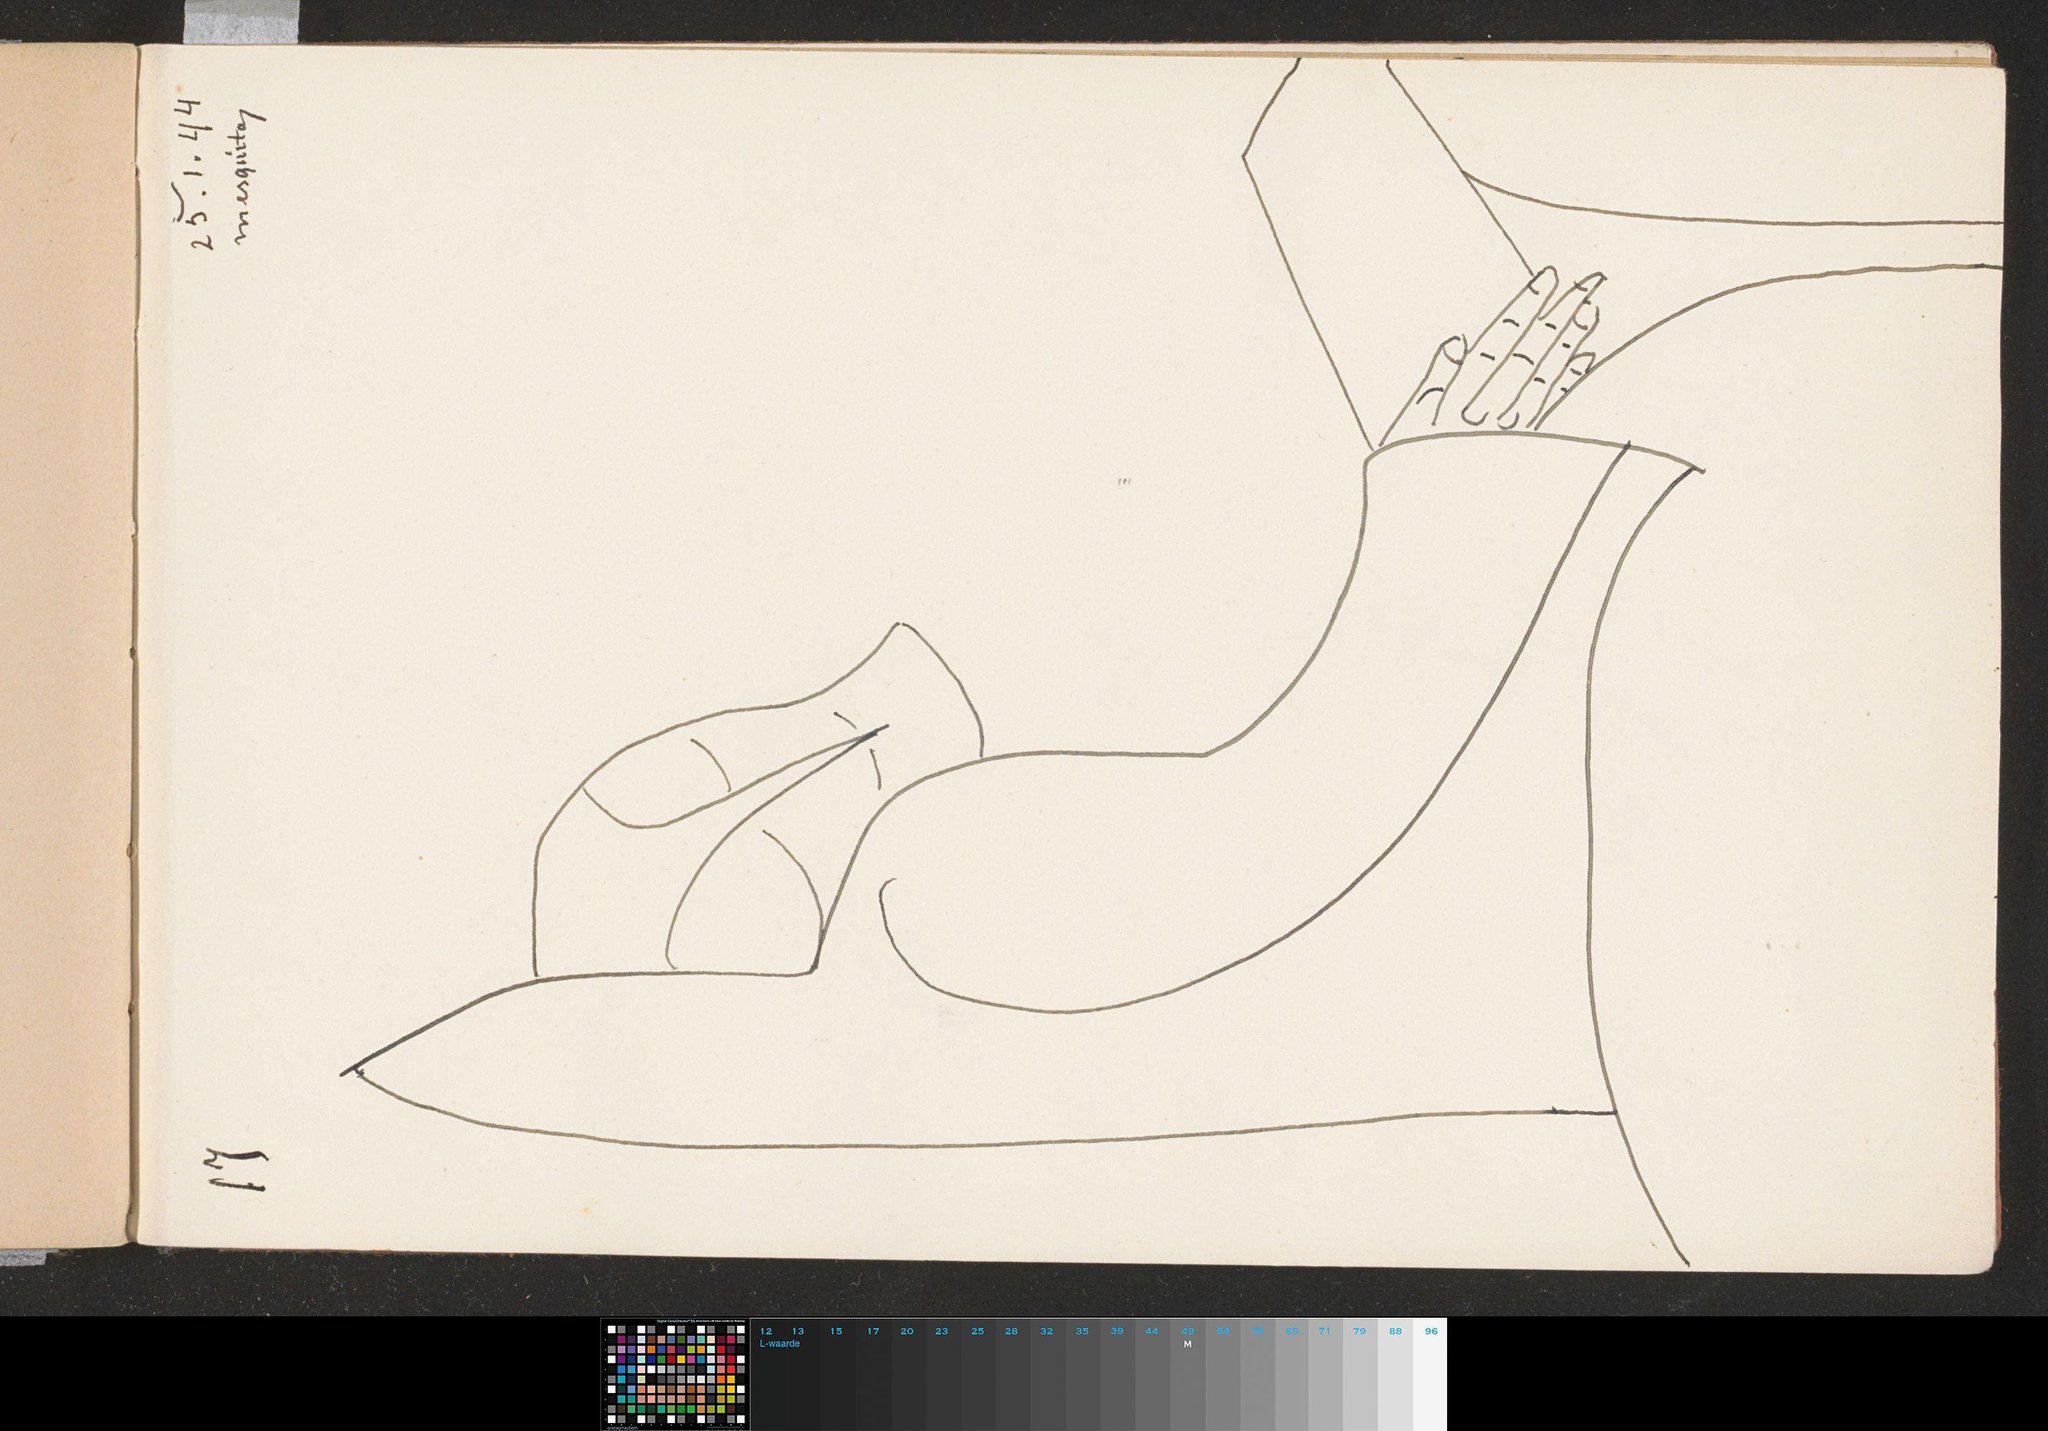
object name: sketchbook leaf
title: Antropomorf figuur met gesloten ogen in profiel naar rechts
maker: samuel jessurun de mesquita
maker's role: draughtsman, print maker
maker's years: 1868-1944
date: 1944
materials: ink, paper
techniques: pen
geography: amsterdam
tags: anthropomorphic beings with parts of abnormal shape, eyes closed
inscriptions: signature and date: ‘17 25.1.44/ mesquita’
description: Blad 17 recto uit een schetsboek met 18 bladen.